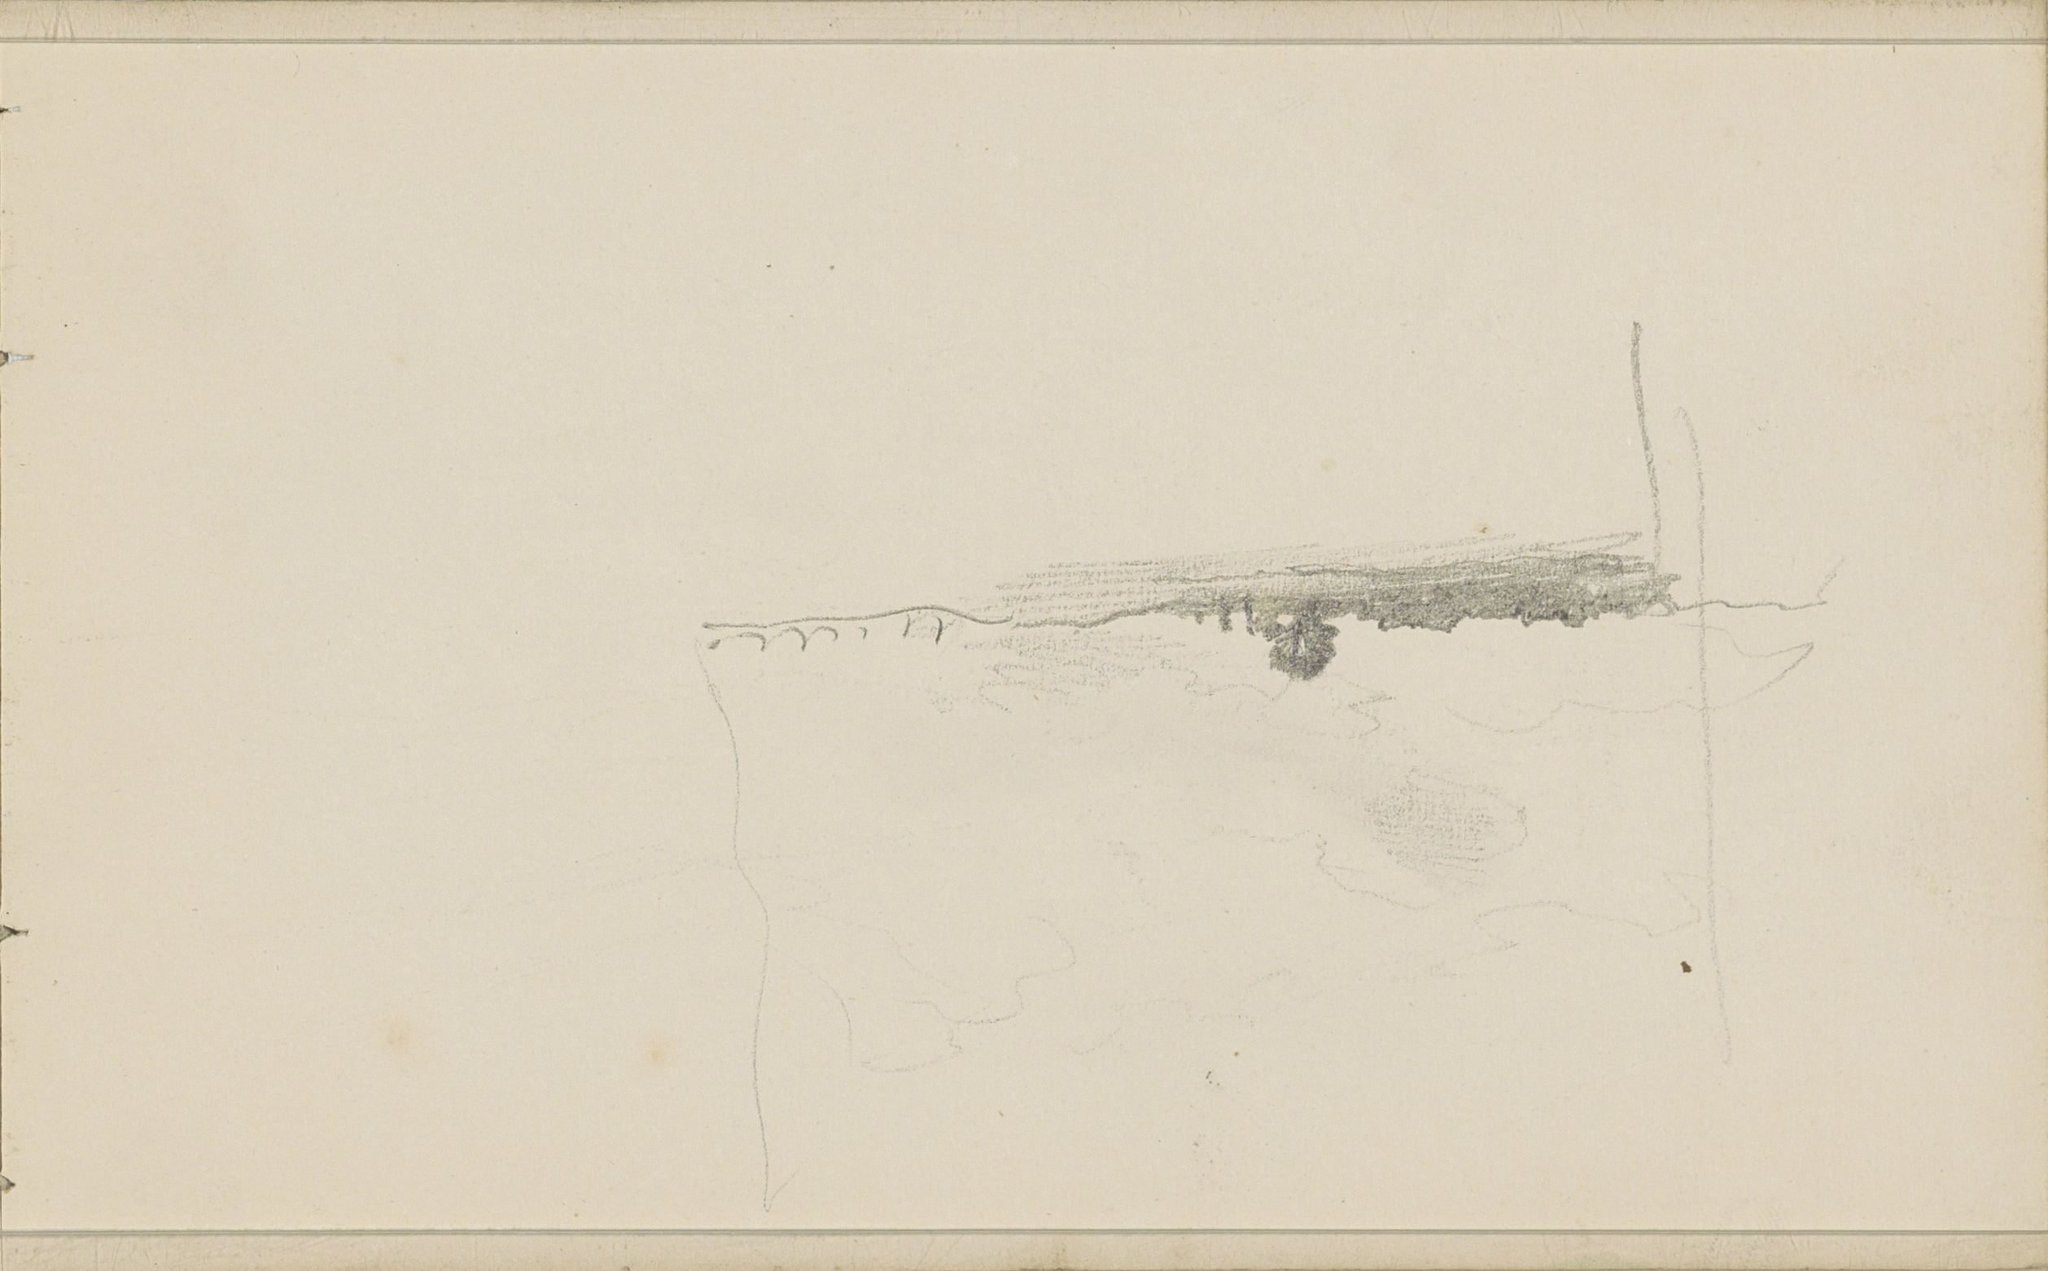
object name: sketchbook leaf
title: Landschap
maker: anton mauve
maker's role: draughtsman, painter, print maker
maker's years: 1838-1888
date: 1848-1888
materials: paper, pencil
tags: landscapes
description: Blad 24 recto uit een schetsboek met 42 bladen.